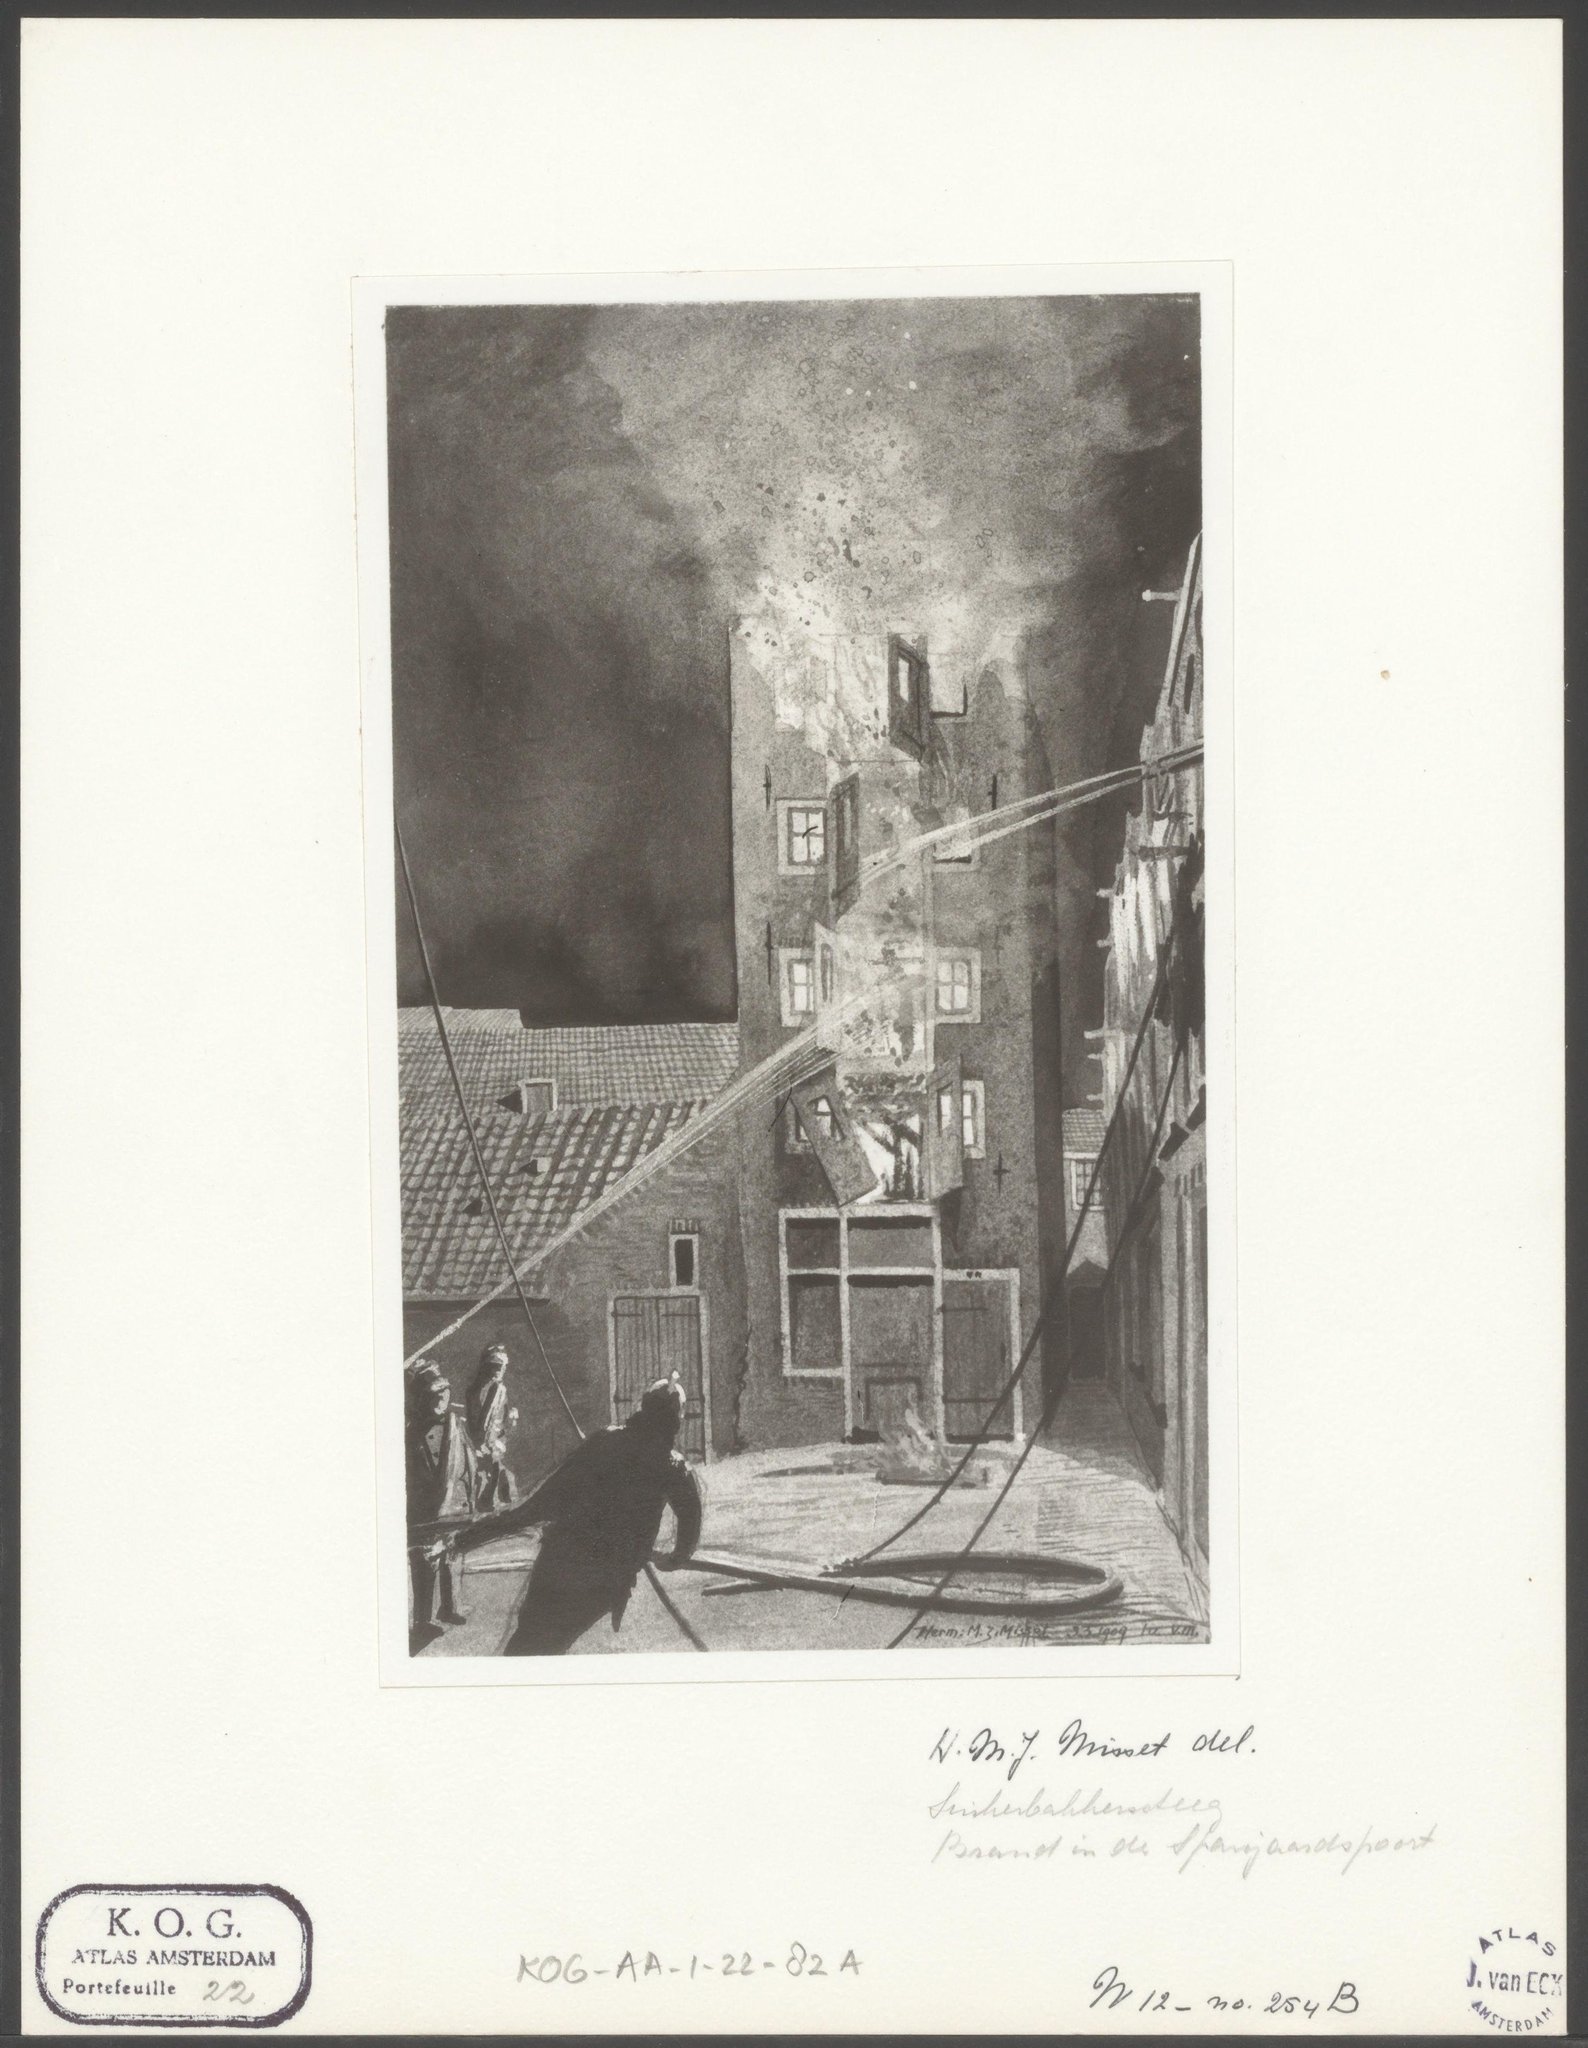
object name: reproduction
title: Fotoreproductie van een tekening van de brand in de Spanjaardspoort, 3 maart 1909, door Herman Misset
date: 1910-1975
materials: paper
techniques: gelatin silver print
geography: netherlands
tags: on fire, ablaze, collapsing building, fire-fighting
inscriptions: collector's mark: Lugt L.800a, collector's mark: Lugt 1641b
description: Onderwerpsrubriek binnen de Atlas Amsterdam: Gemeentewerken: B. Branden in particuliere gebouwen.